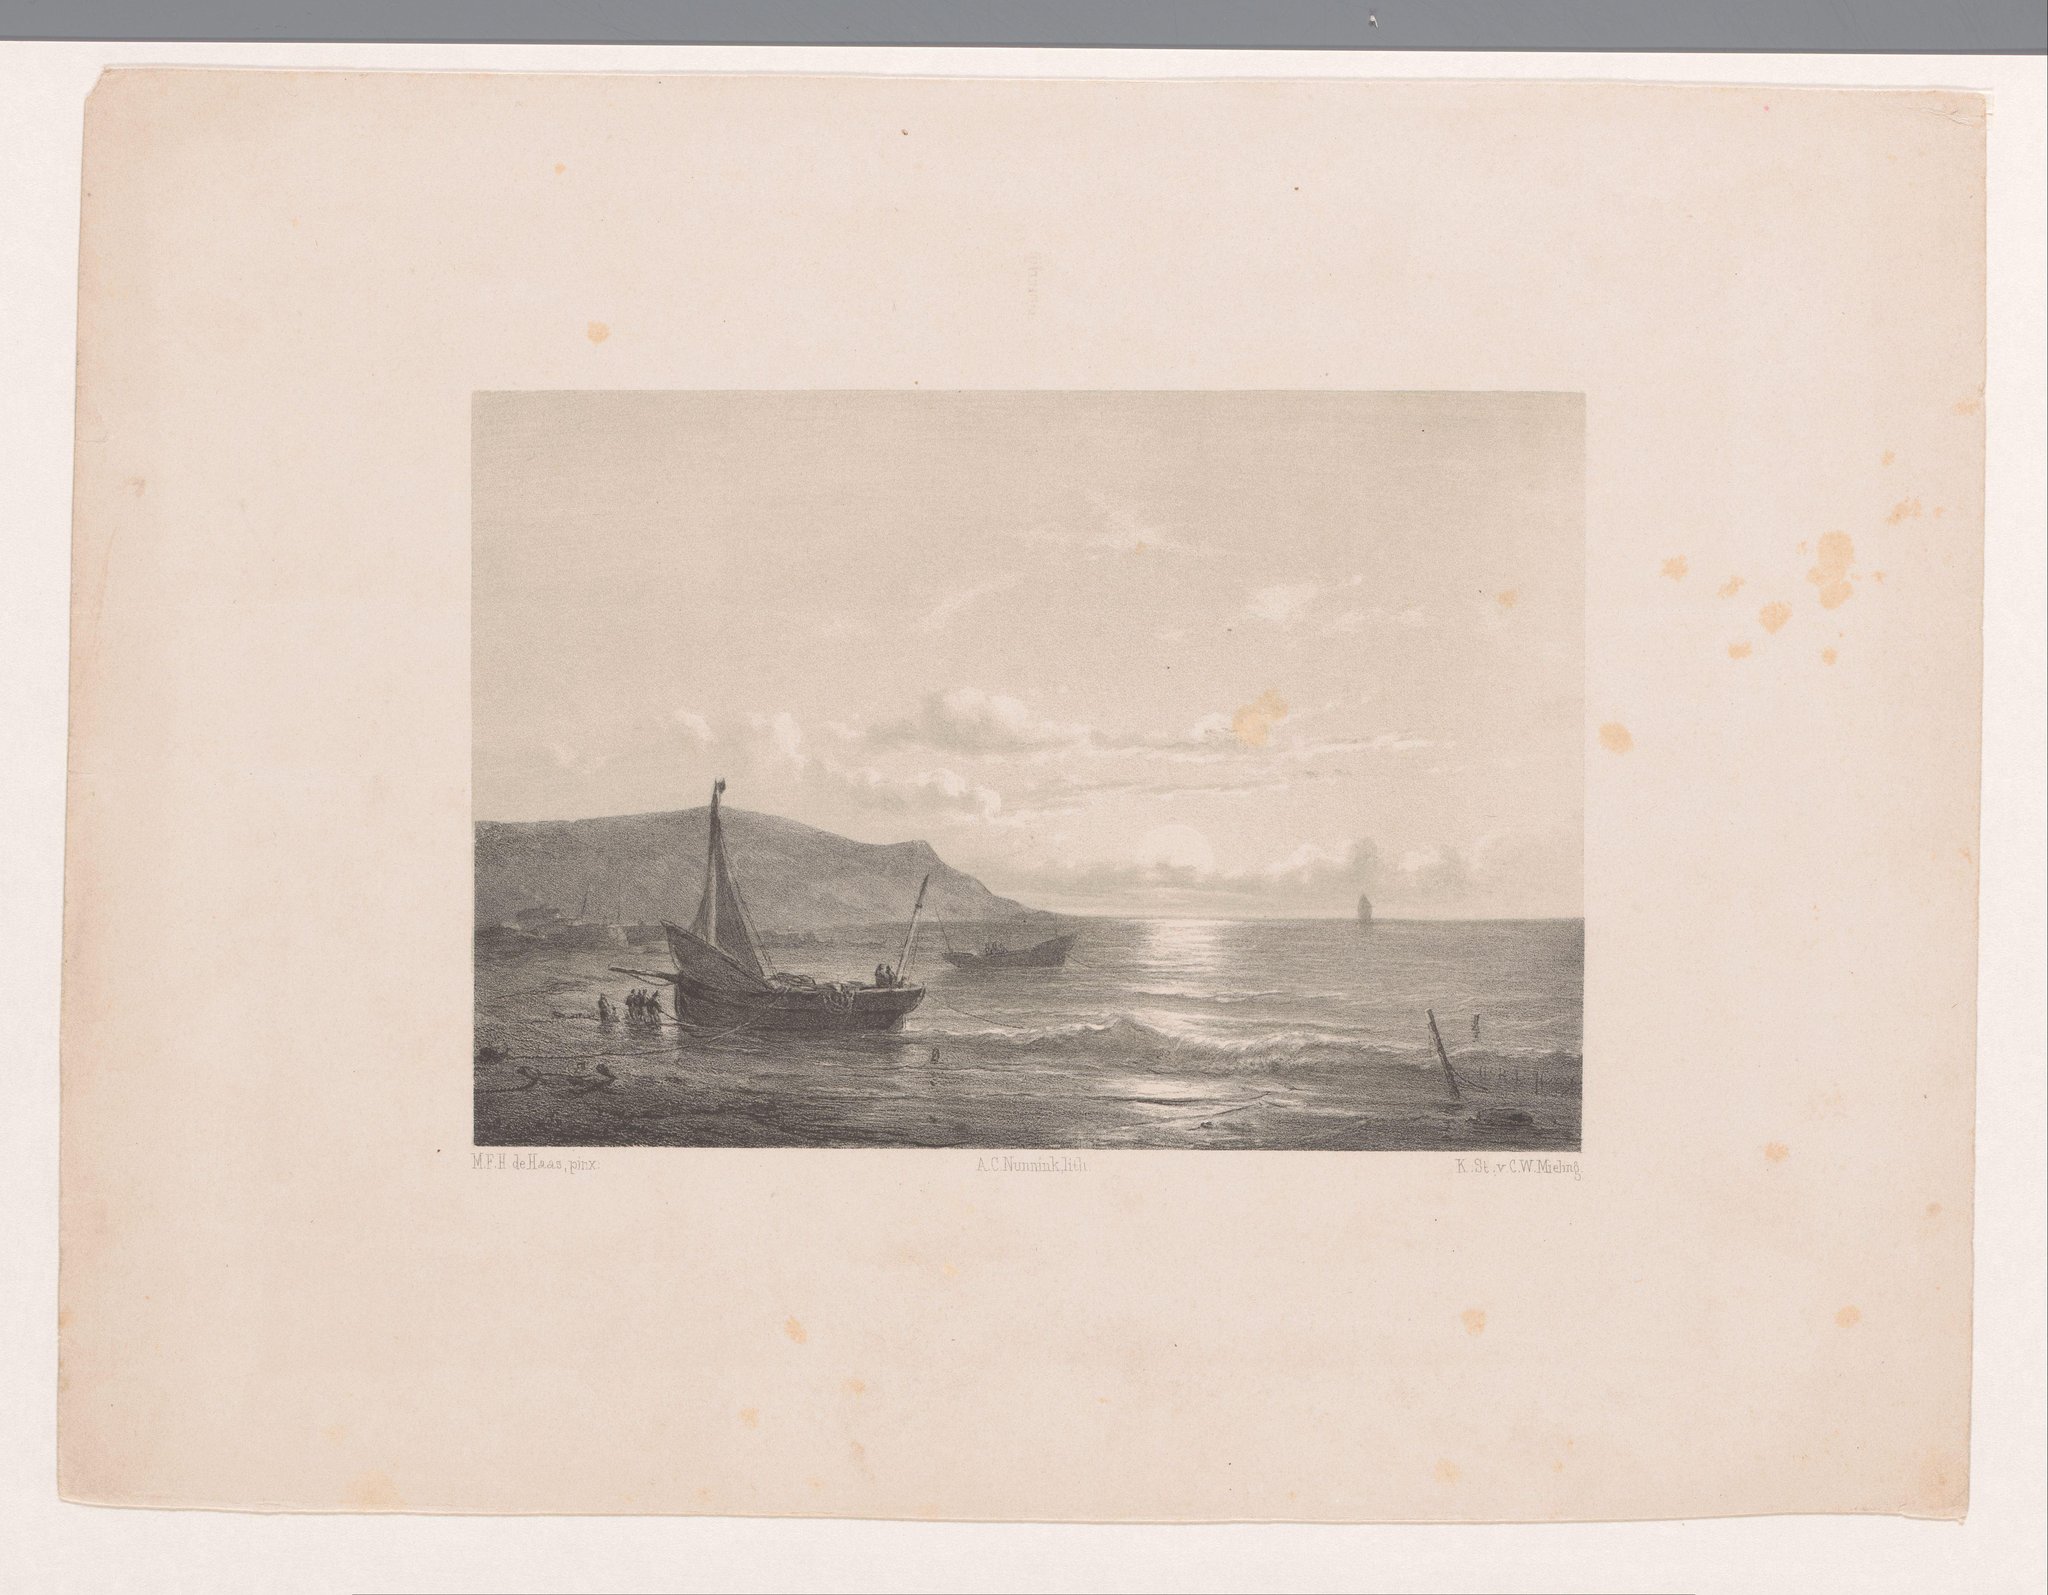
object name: print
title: Aangemeerde boten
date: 1847-1865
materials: paper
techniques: tone lithography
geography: the hague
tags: sailing-ship, sailing-boat, beach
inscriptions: collector's mark: Lugt 2228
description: Zeilboten aangemeerd op het strand. In de achtergrond vaart een schip op zee.